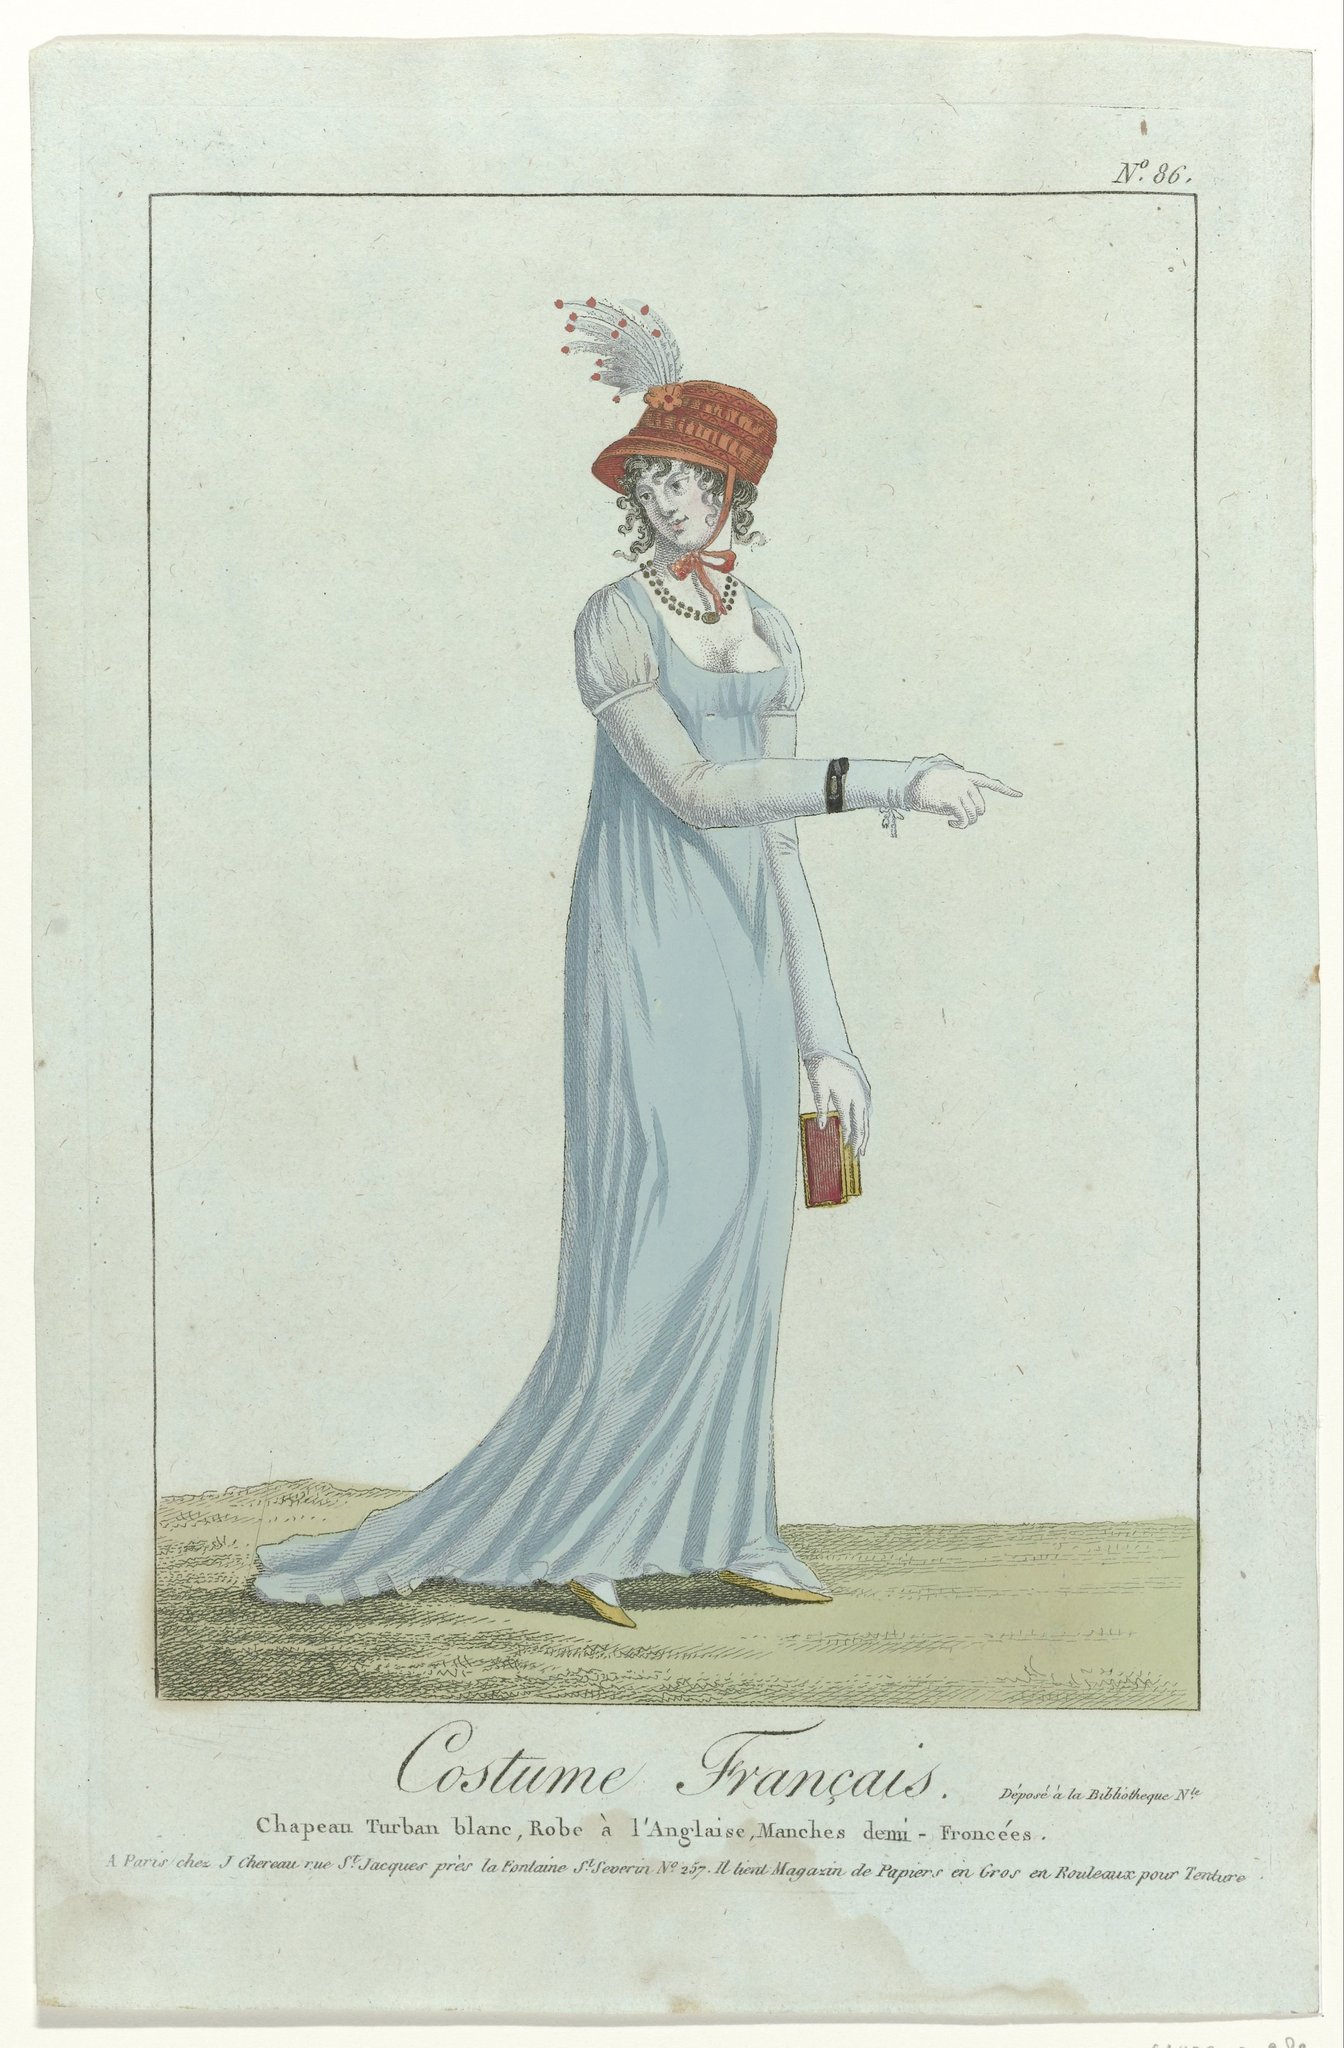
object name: fashion print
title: Costume Français, puis Nouveau Costume Parisien 1799-1810, No. 86 : Chapeau Turban blanc (...)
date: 1799-1810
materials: paper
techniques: engraving, etching, hand coloring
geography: paris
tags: dress, gown: robe à l'anglaise (+ women's clothes), fashion plates, head-gear: hat (+ women's clothes), book, sleeves (+ women's clothes), bracelet, wristlet (+ women's clothes), necklace (+ women's clothes)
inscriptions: caption: ‘Chapeau Turban blanc, Robe à l'Anglaise, manches demi-Froncées.’, address: ‘A Paris, chez J. Chéreau. Rue Jacques près la Fontaine Severin, No. 257. Il tient Magasin de Papiers en Gros en Rouleaux pour Tenture.’, caption: ‘Déposé à la Bibliothèque N.ale’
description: Vrouw naar rechts, op het hoofd een hoed: 'Chapeau Turban blanc', versierd met veren. Zij draagt een 'Robe à l'Anglaise' met sleepje, met lange mouwen die bij de schouders zijn gesmockt. Accessoires: collier, armband, platte schoenen met puntige neuzen. Boek in de linkerhand. De prent maakt deel uit van een serie van 142 modeprenten, waarvan er 115 zijn geïdentificeerd, uitgegeven door J. Chéreau, Parijs, 1799-1810.